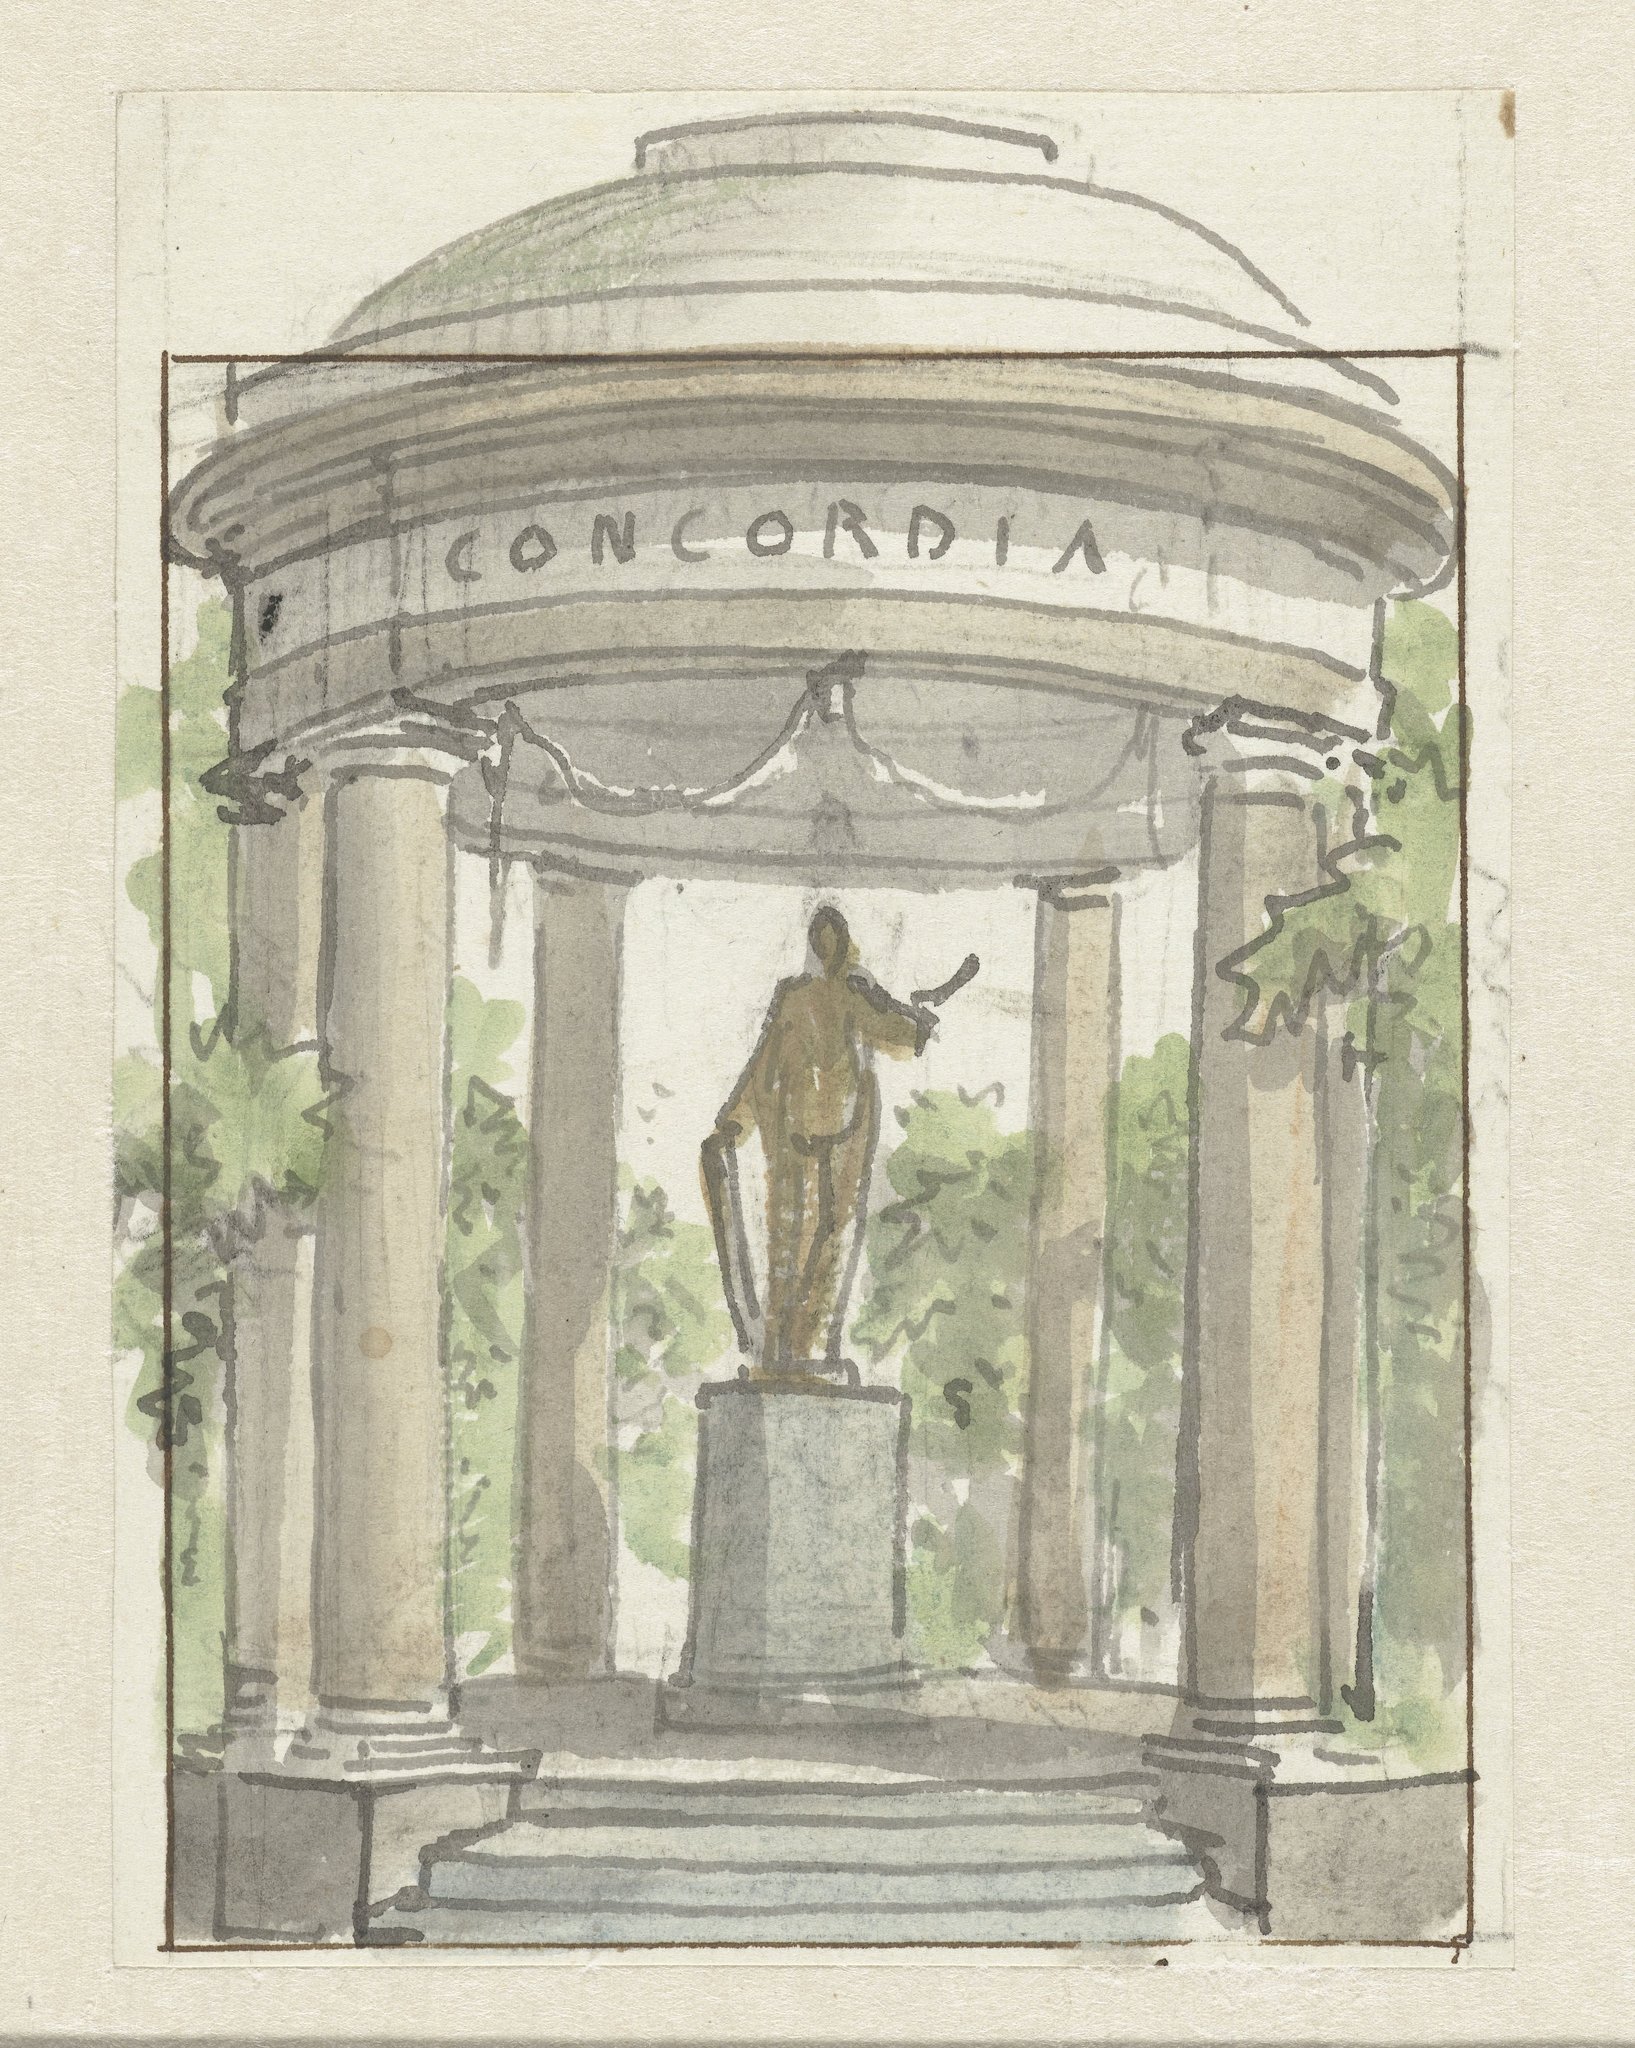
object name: design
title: Ontwerp voor een Tempel der Eendracht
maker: jurriaan andriessen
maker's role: draughtsman, painter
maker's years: 1742-1819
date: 1752-1819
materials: graphite, ink, paper, watercolor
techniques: brush, pen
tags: agreement, unity; 'concordia', 'concordia insuperabile', 'concordia militare', 'concordia di pace', 'unione civile' (ripa)